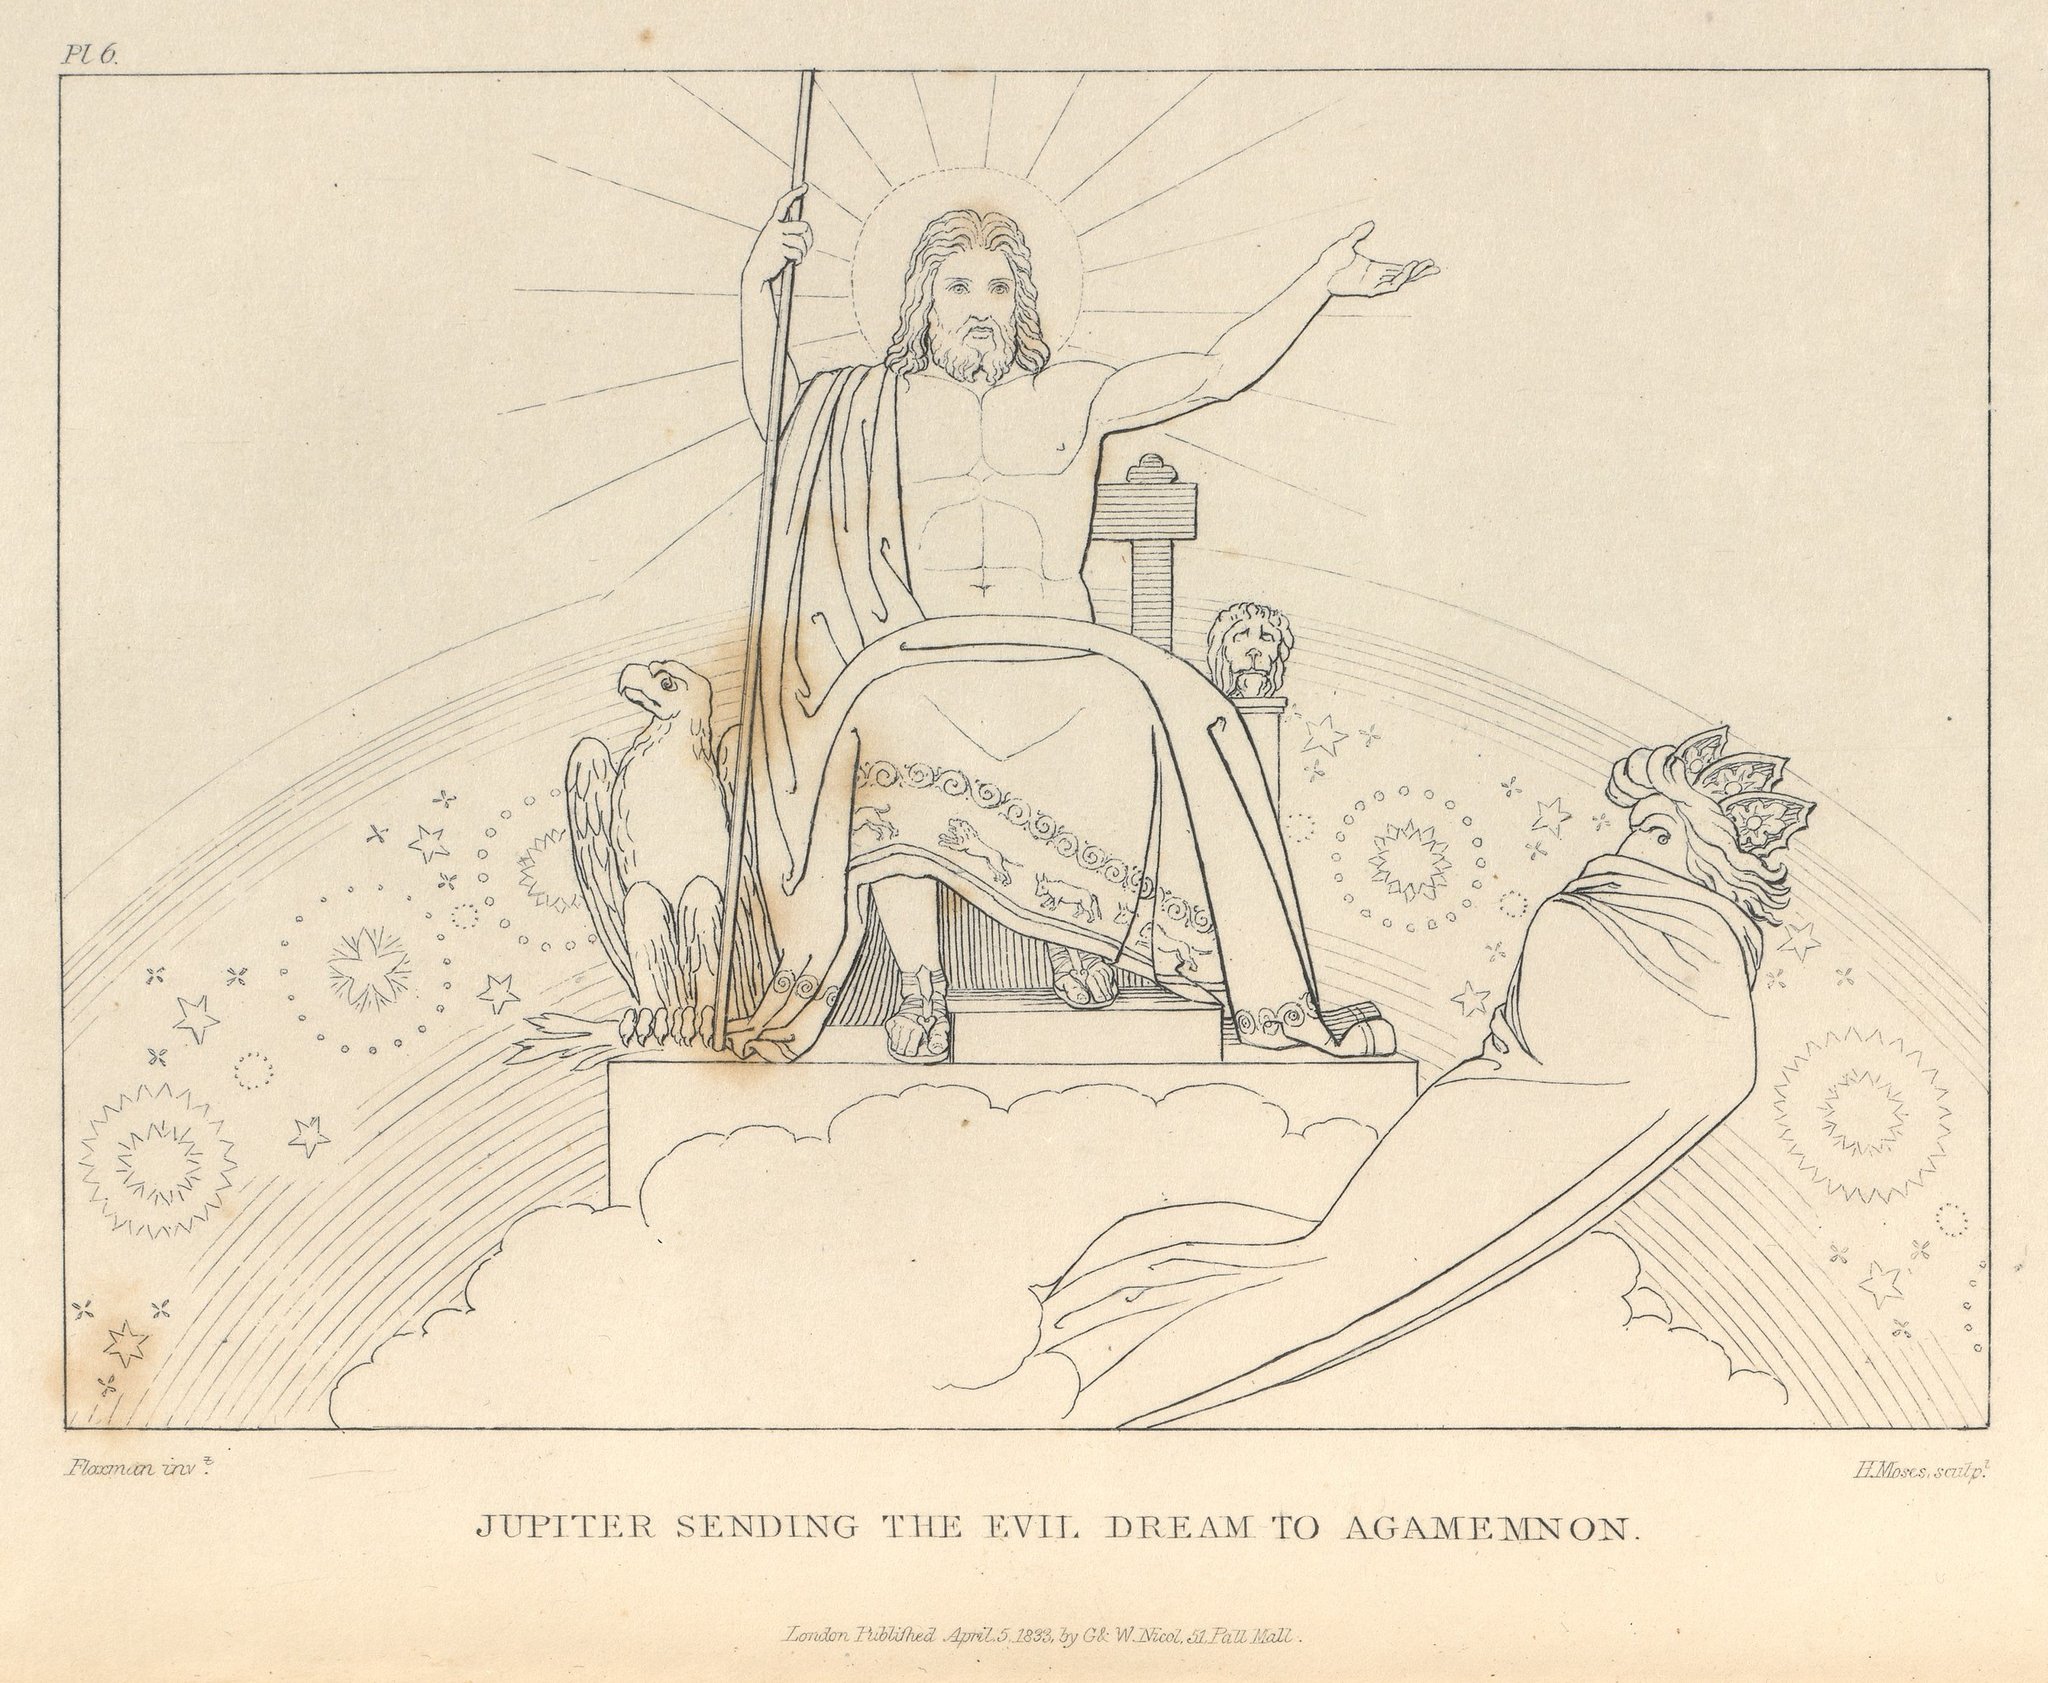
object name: book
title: The Iliad and the Odyssey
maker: john flaxman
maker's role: artist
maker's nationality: british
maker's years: 1755-1826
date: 1834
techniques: engraving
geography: england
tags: eagles,men